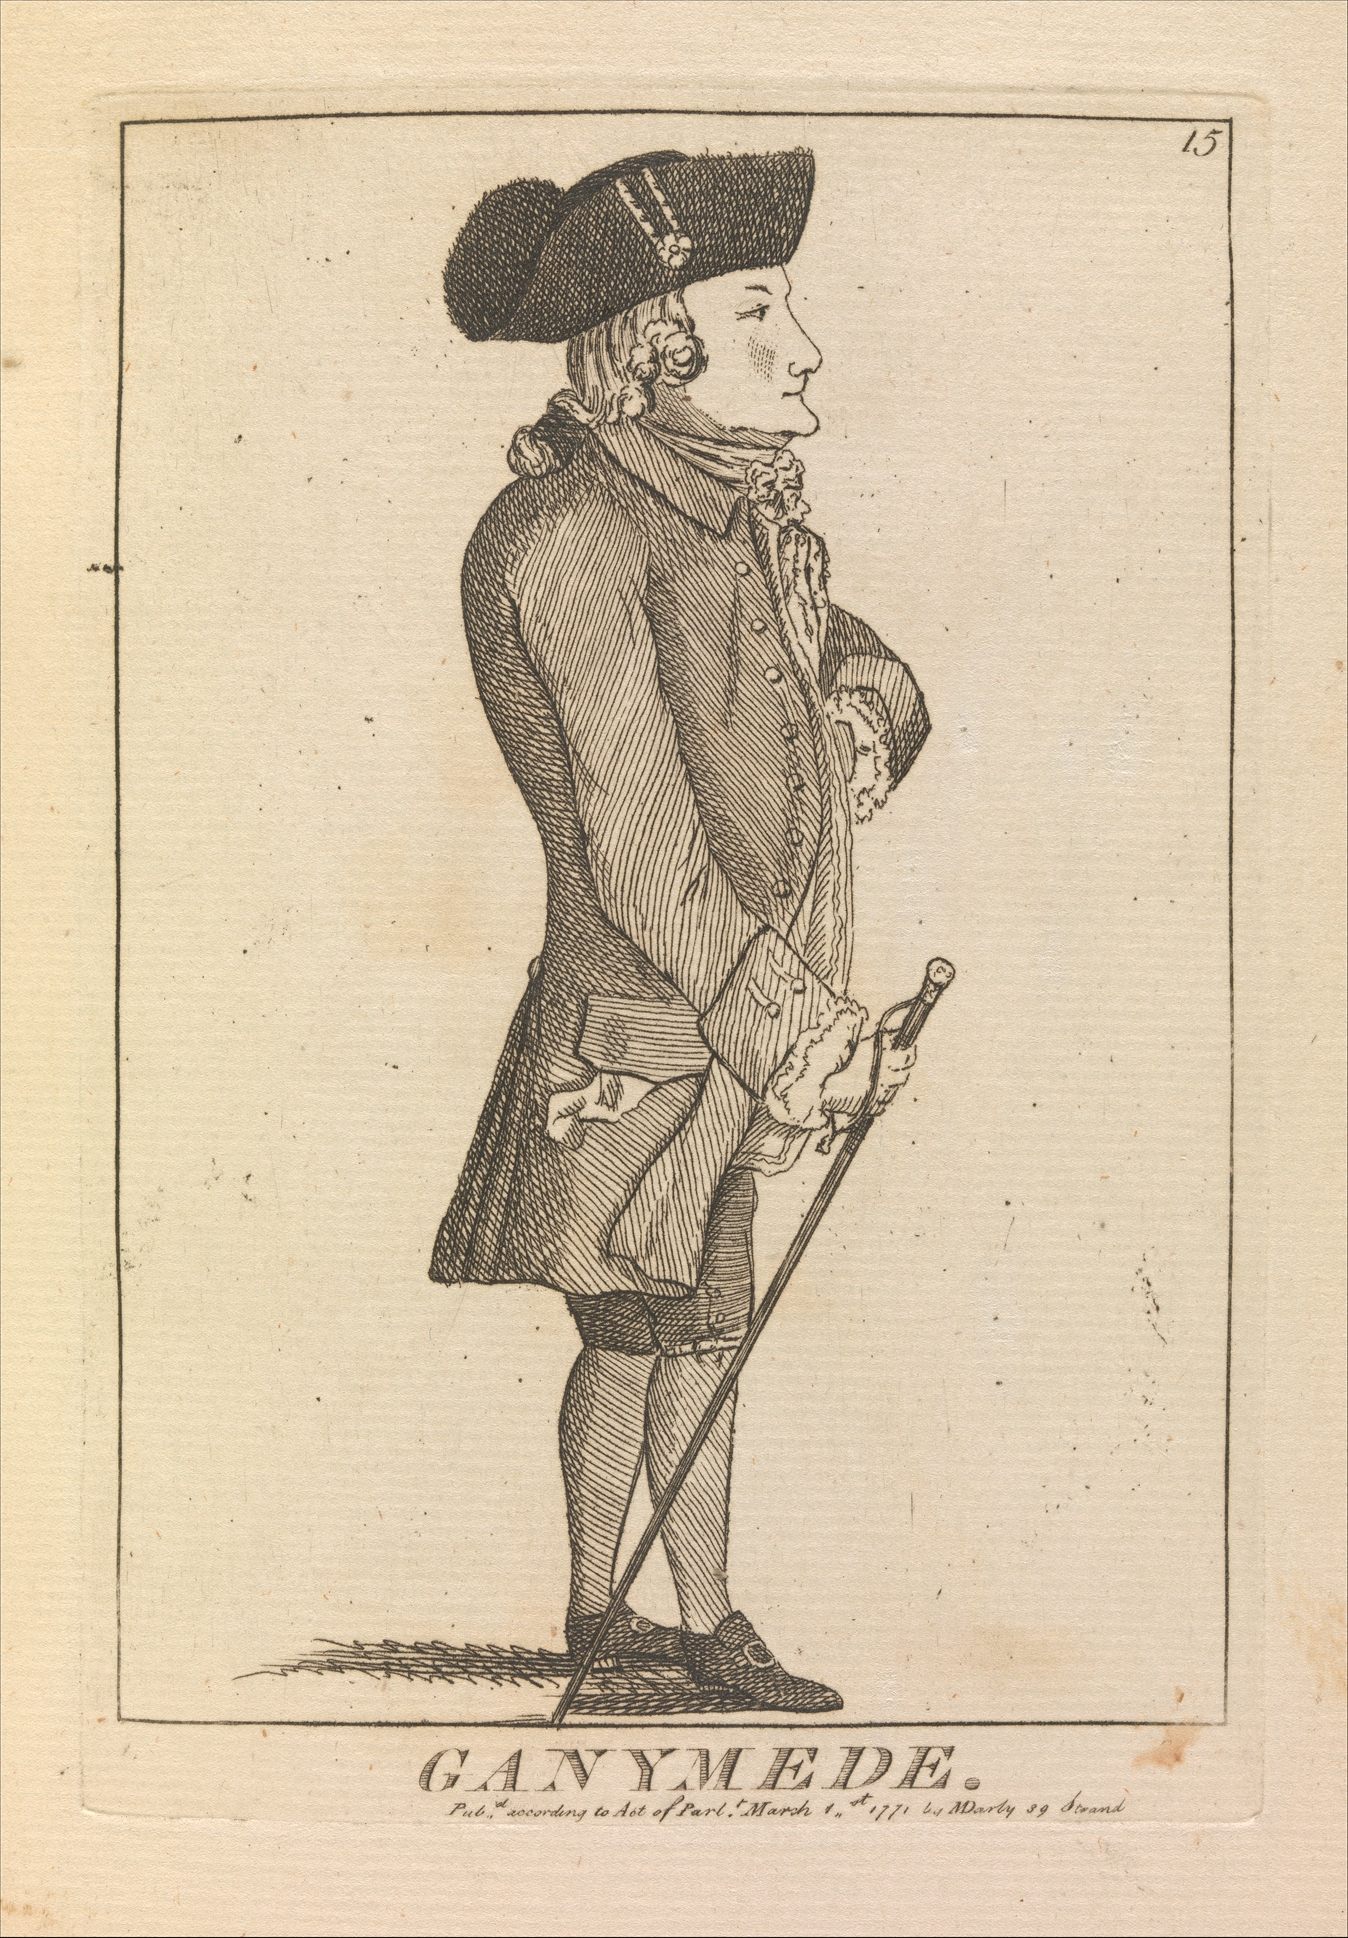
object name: print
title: Ganymede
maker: matthias darly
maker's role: publisher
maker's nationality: british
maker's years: 1720-1780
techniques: etching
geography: london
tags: men,profiles